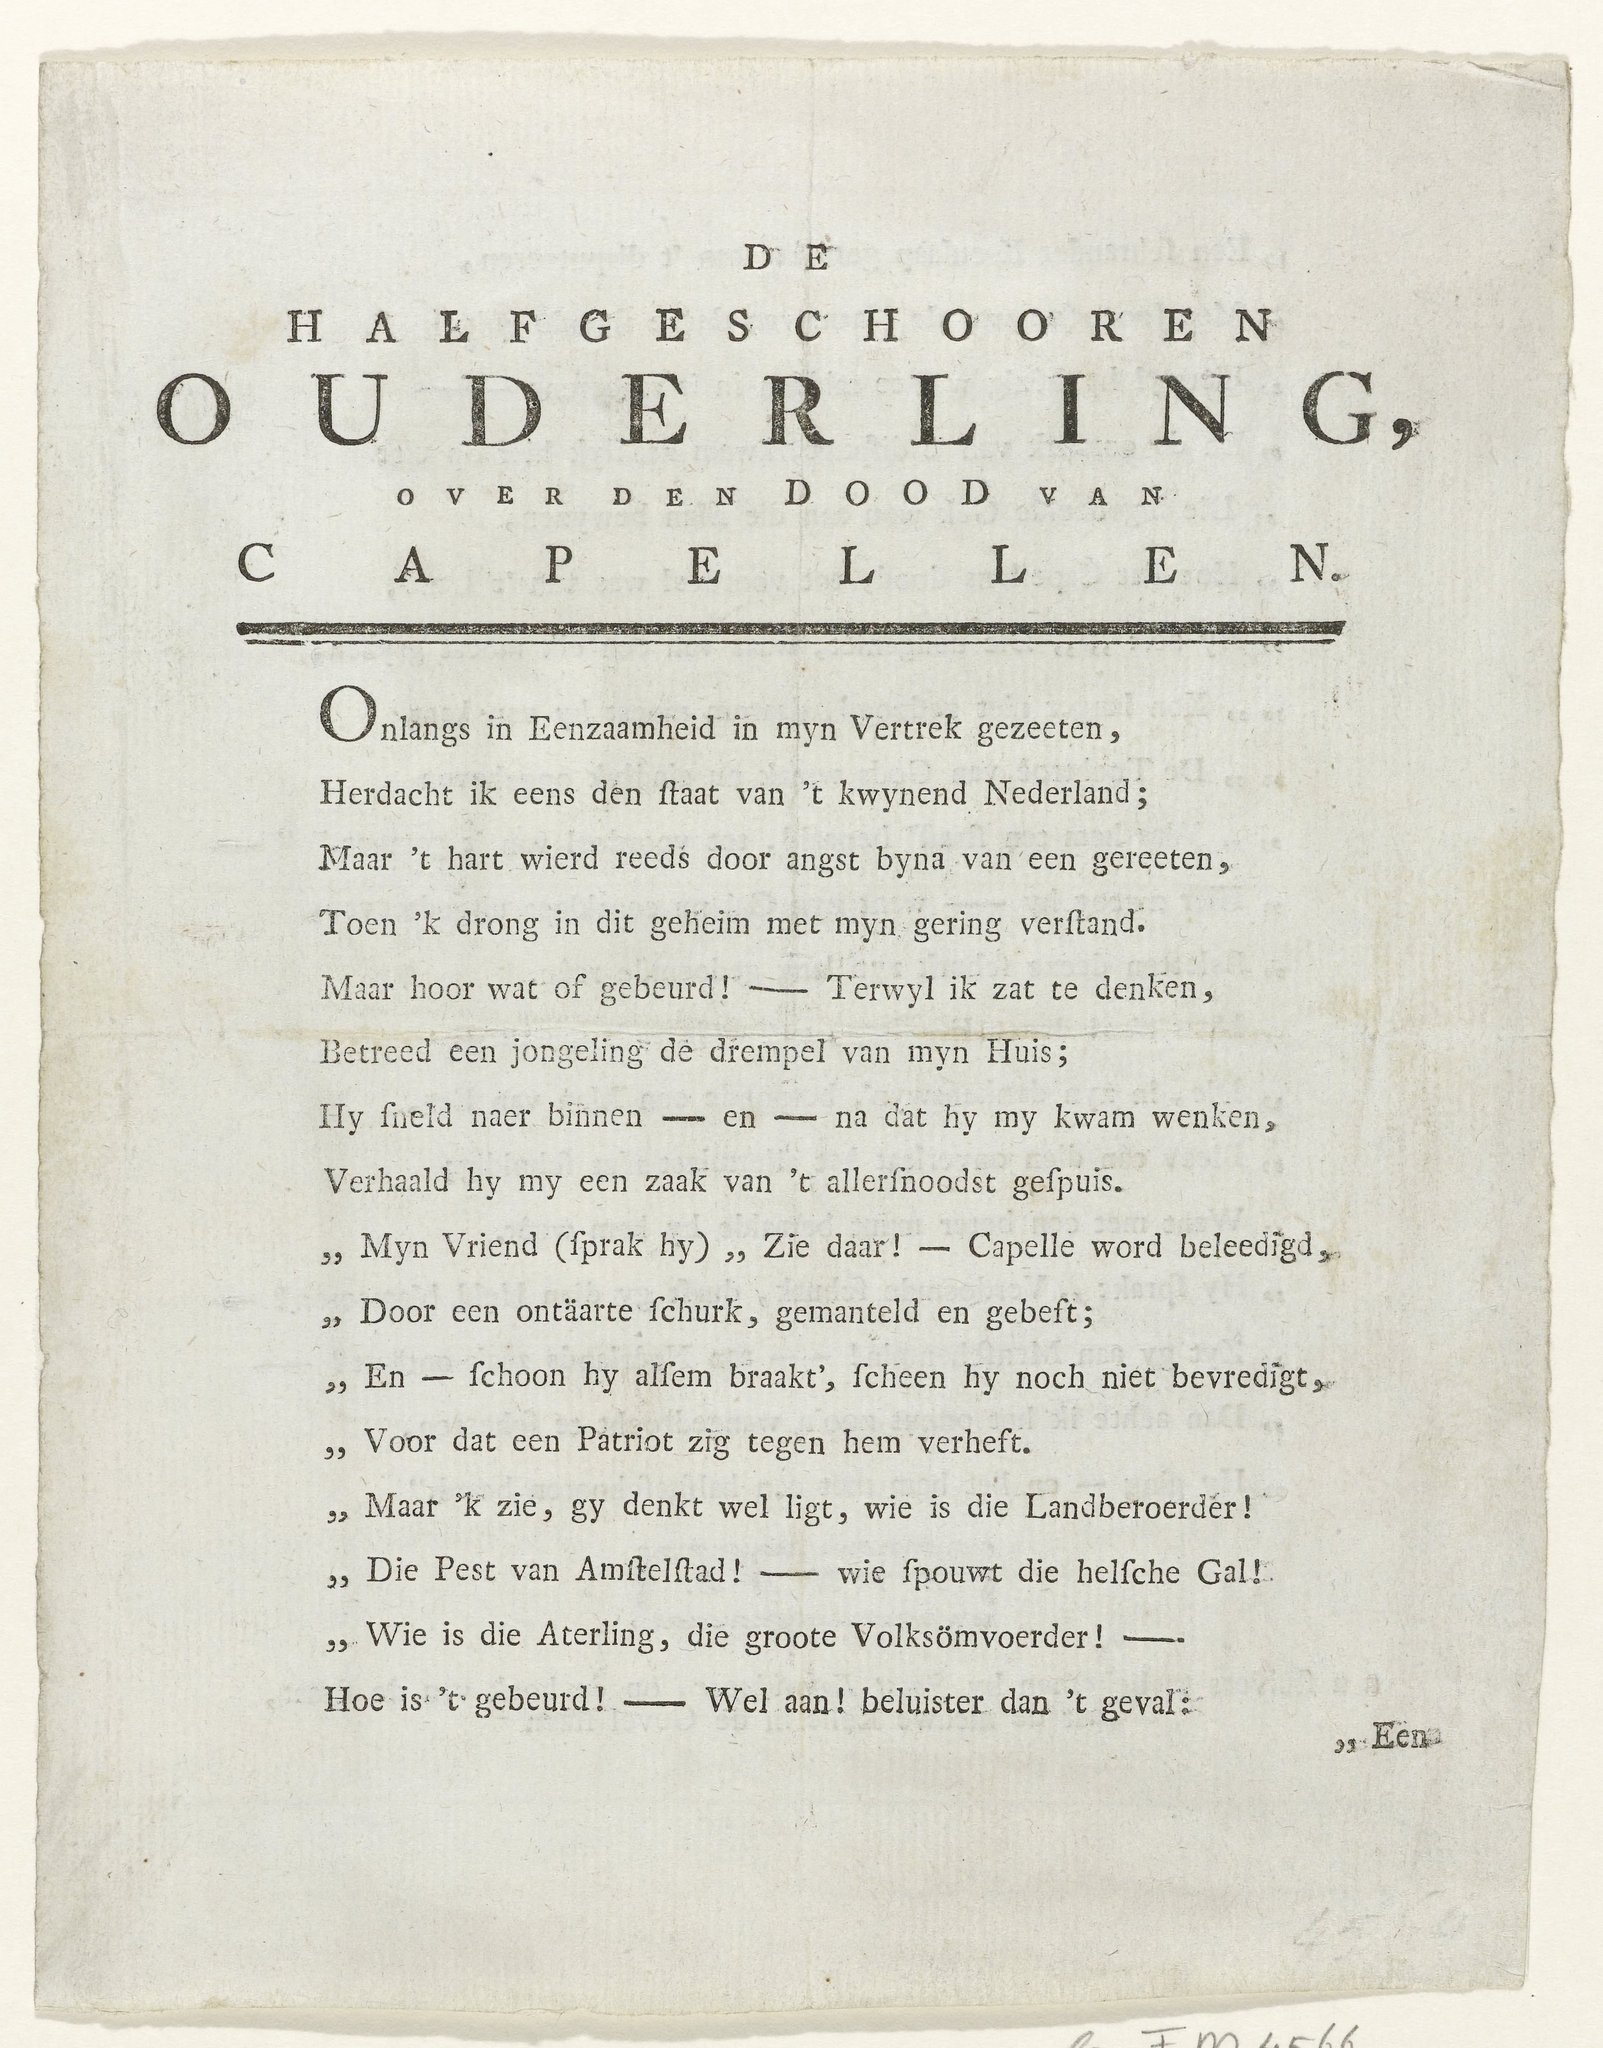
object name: text sheet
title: Spotvers op de Orangegezinde ouderling Pieter Joosten, 1784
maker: Anonymous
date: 1784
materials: paper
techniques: letterpress printing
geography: northern netherlands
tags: politician, joan derk van der capellen tot den pol, amsterdam, patriots (1780-1795)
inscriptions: collector's mark: Lugt 2228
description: Spotvers op de prinsgezinde ouderling en kousenverkoper Pieter Joosten die zich in zijn kousenwinkel in Amsterdam liet scheren door een patriotse barbier en laatdunkend spreekt over de dood van Joan Derk van der Capellen tot den Pol, augustus 1784. Tekstblad bedrukt op beide zijden.